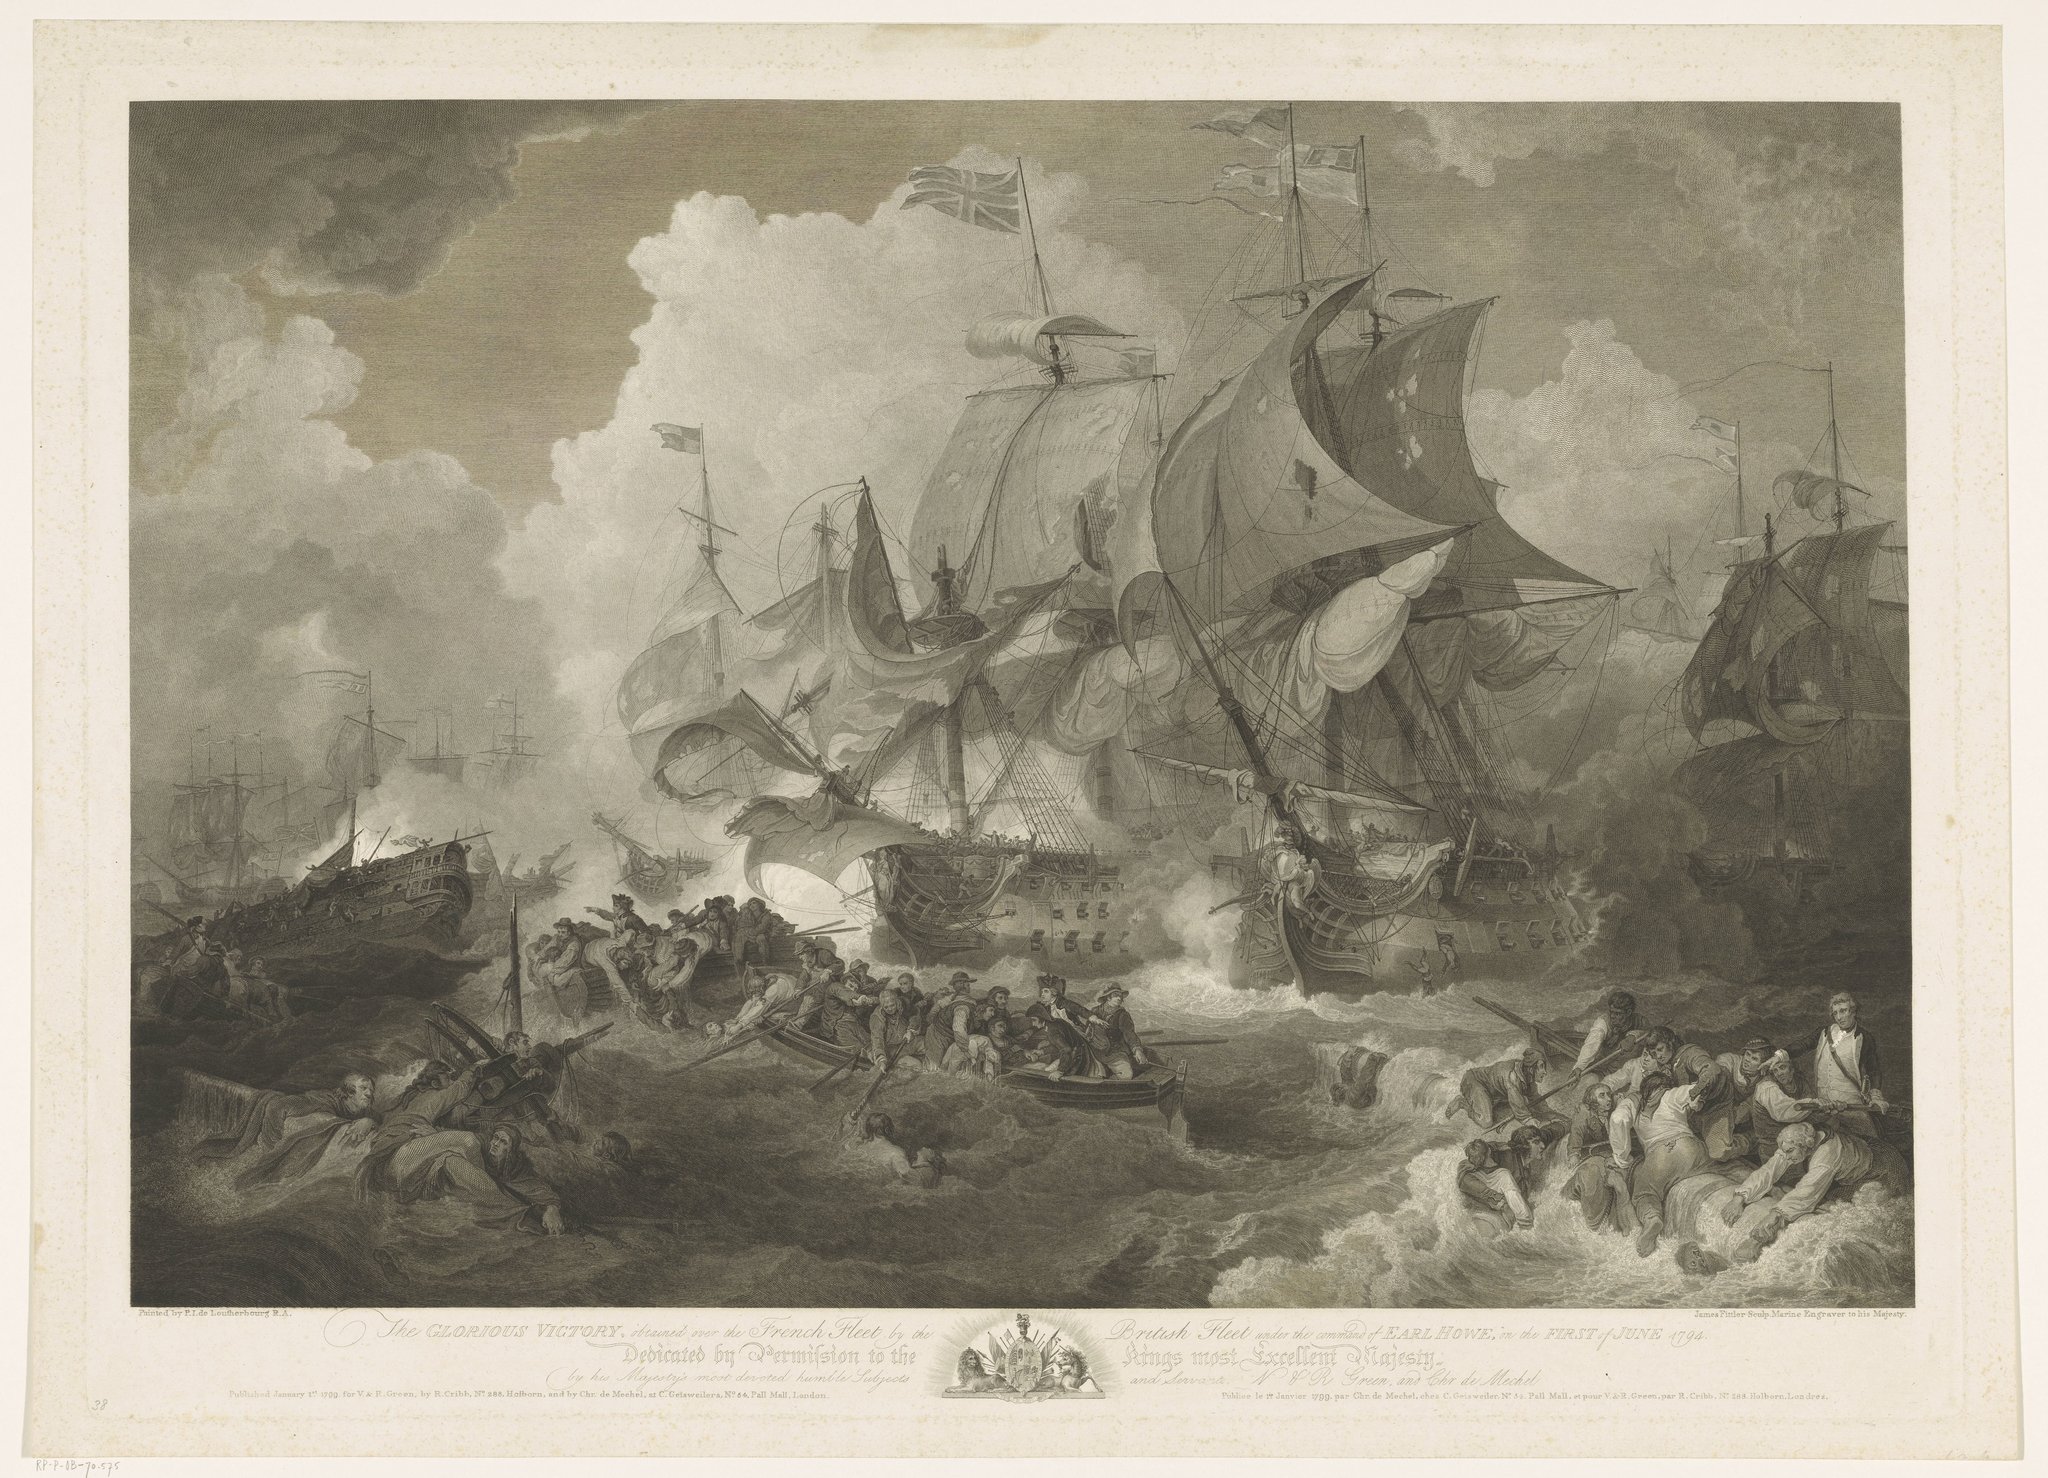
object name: print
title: The Glorious Victory, obtained over the French Fleet by the British Fleet, under the command of Earl Howe (...)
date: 1799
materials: paper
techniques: engraving, etching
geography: holborn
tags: battle (+ naval force), armorial bearing, heraldry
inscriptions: collector's mark: Lugt 12, check stamp: ‘[C...]’